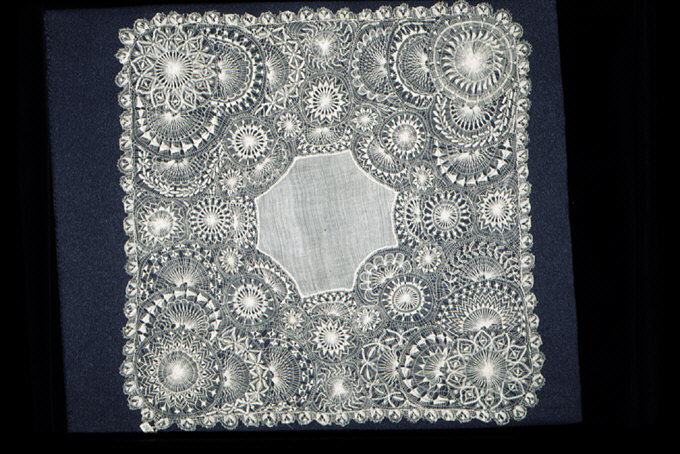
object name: handkerchief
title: Lace handkerchief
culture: paraguayan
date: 1834-1866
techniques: embroidery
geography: paraguay